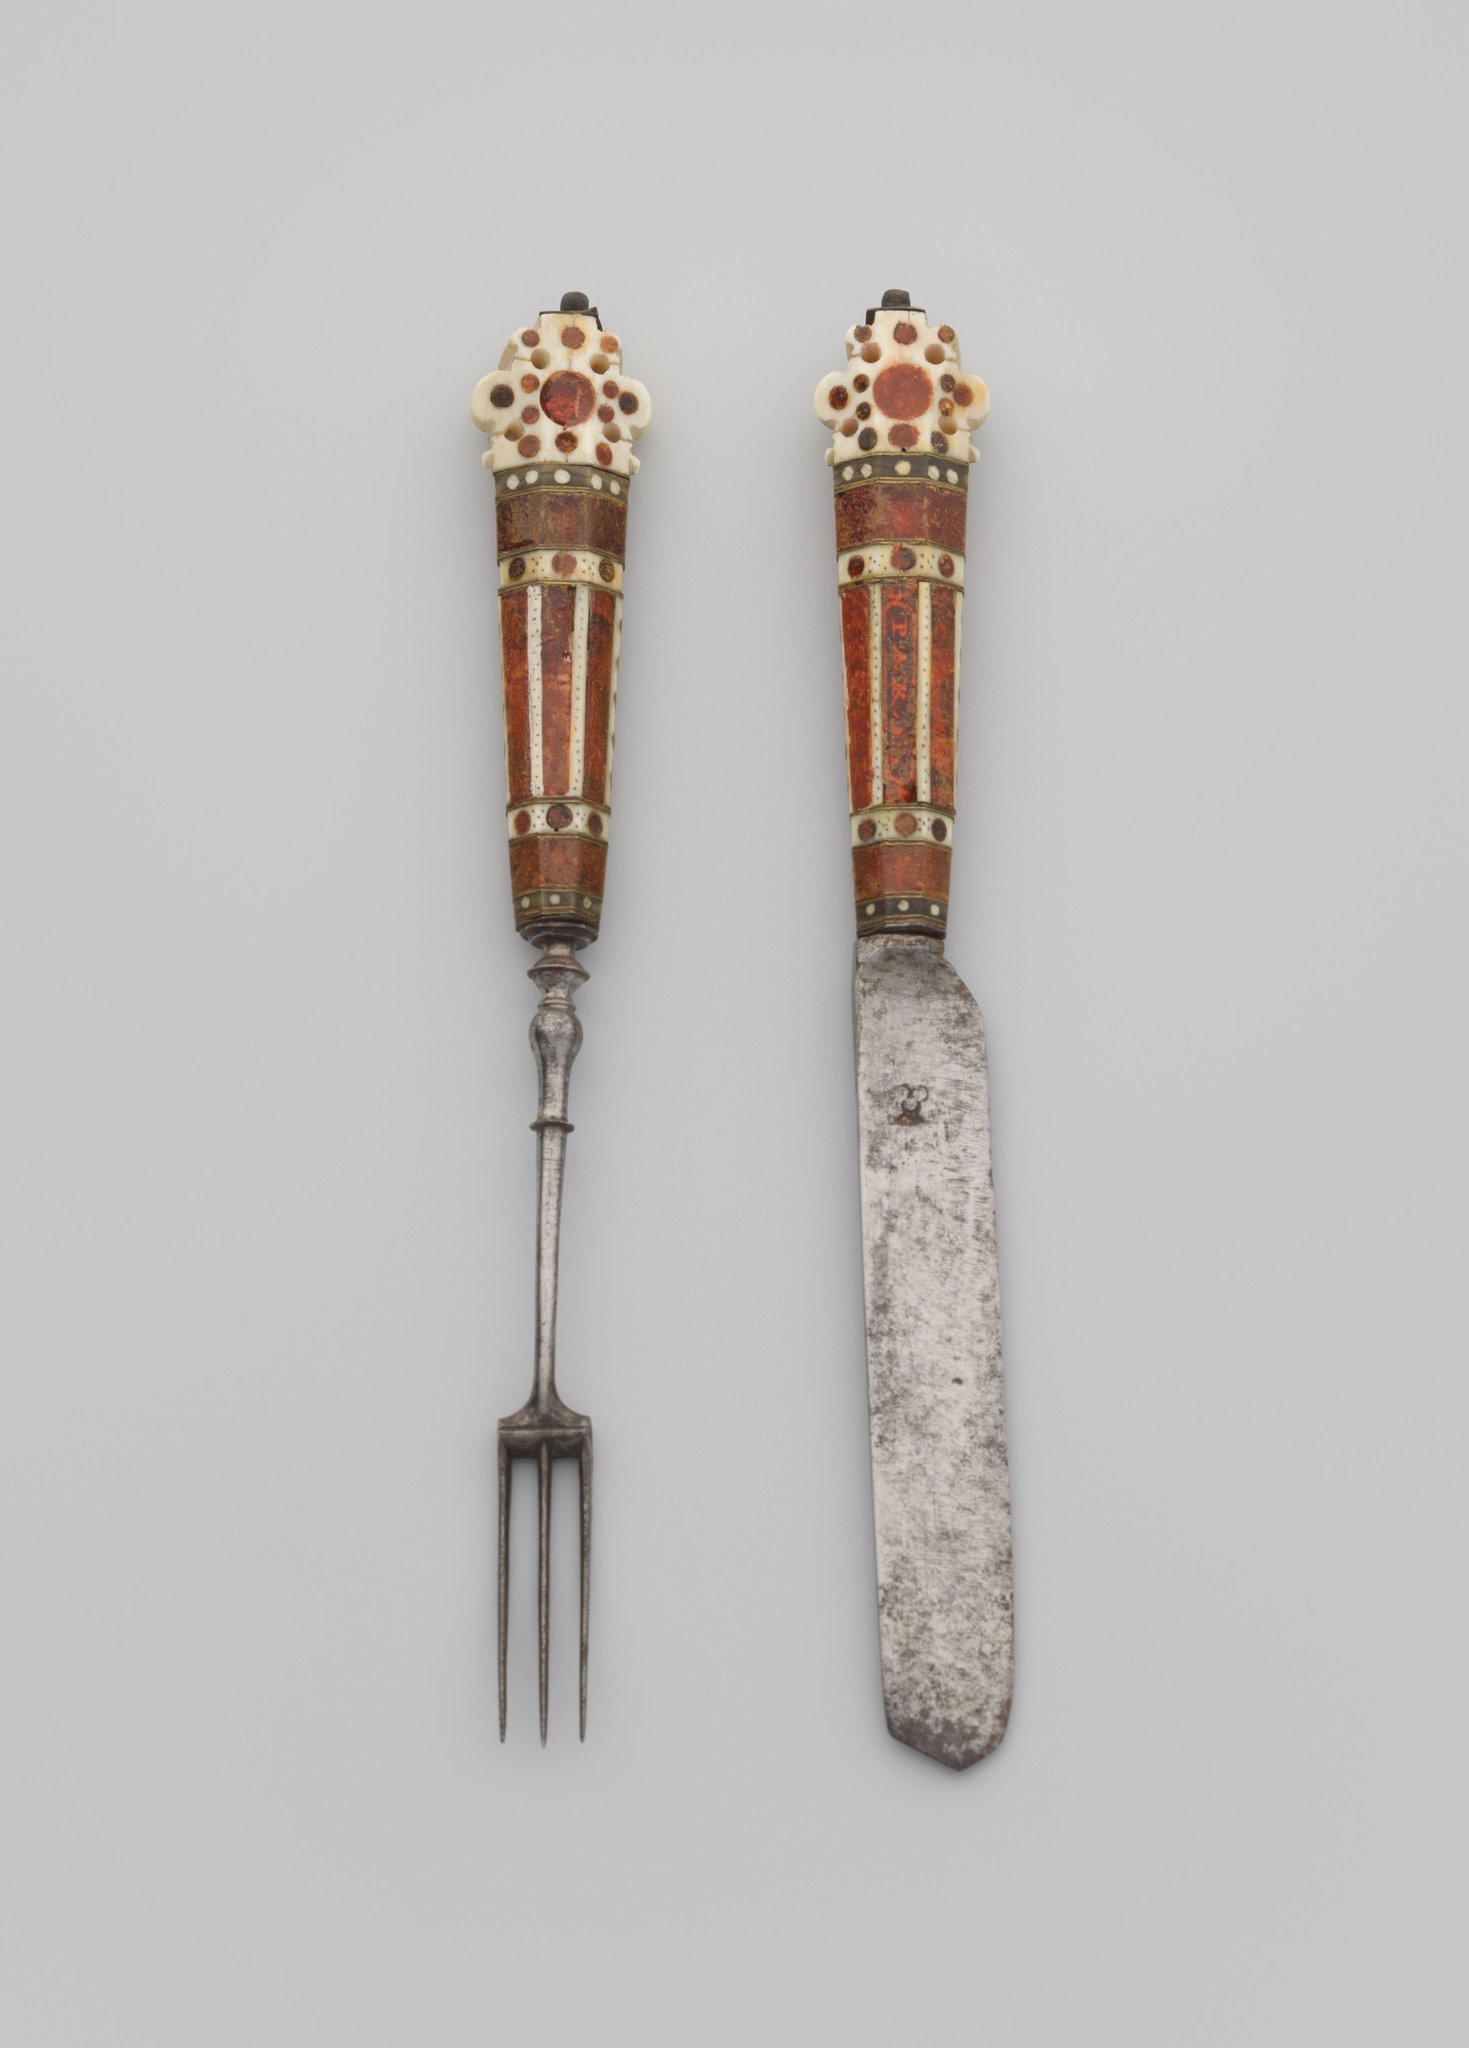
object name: fork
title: Vork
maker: Anonymous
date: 1600-1625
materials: ivory, silver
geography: königsberg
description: Een vork met een barnsteen ivoren heft en zilver knopjes. Foudraal van deze vork is verdwenen.